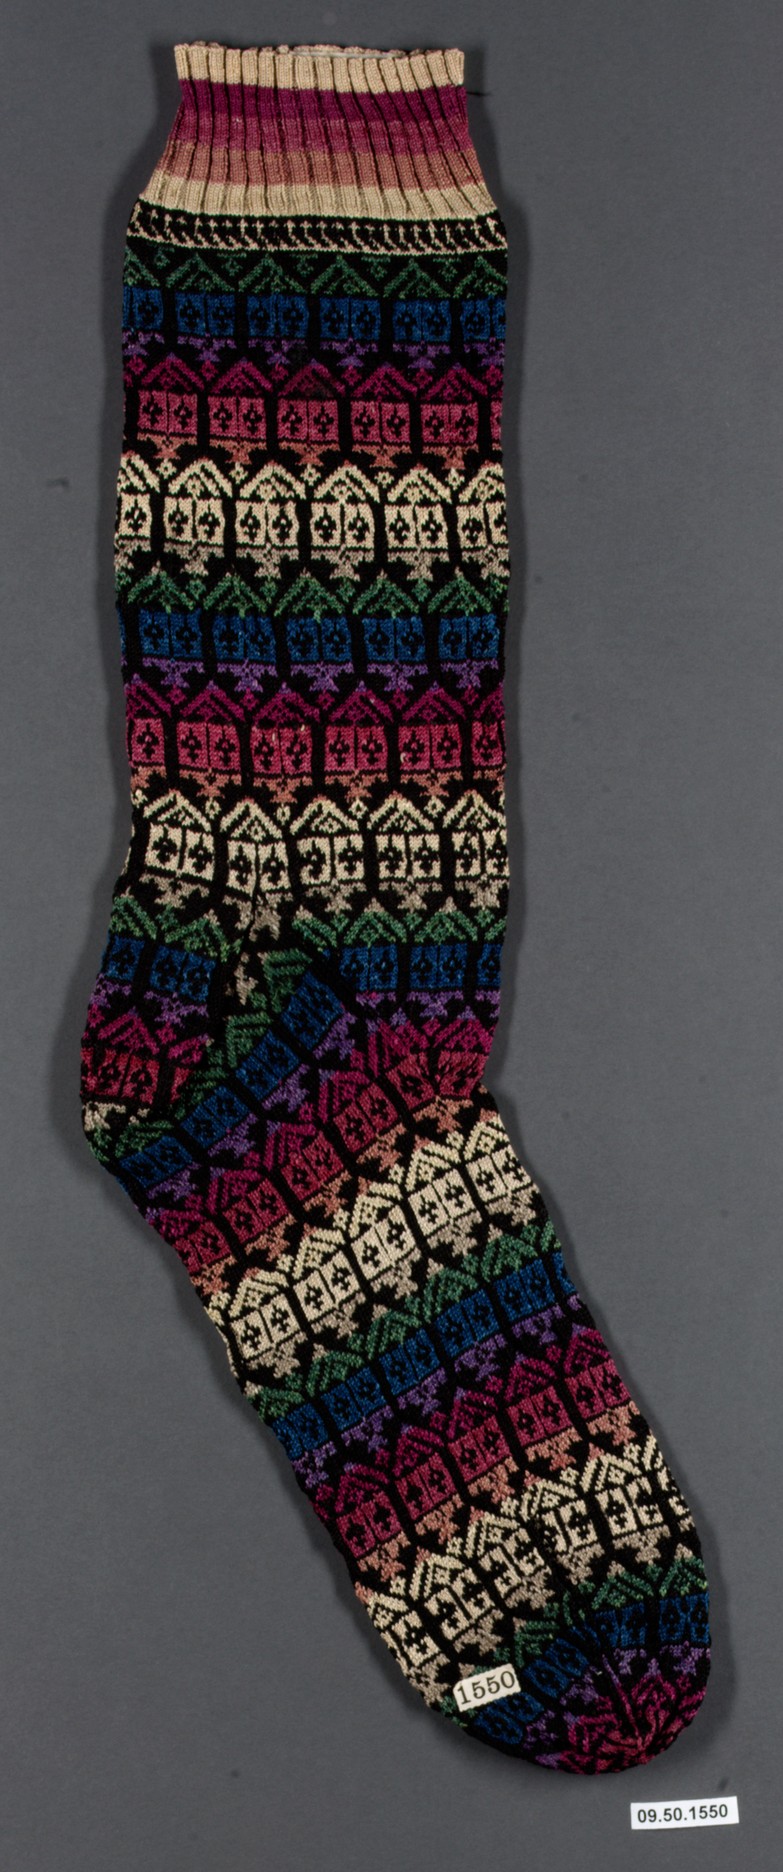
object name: sock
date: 1801-1900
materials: silk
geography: turkey